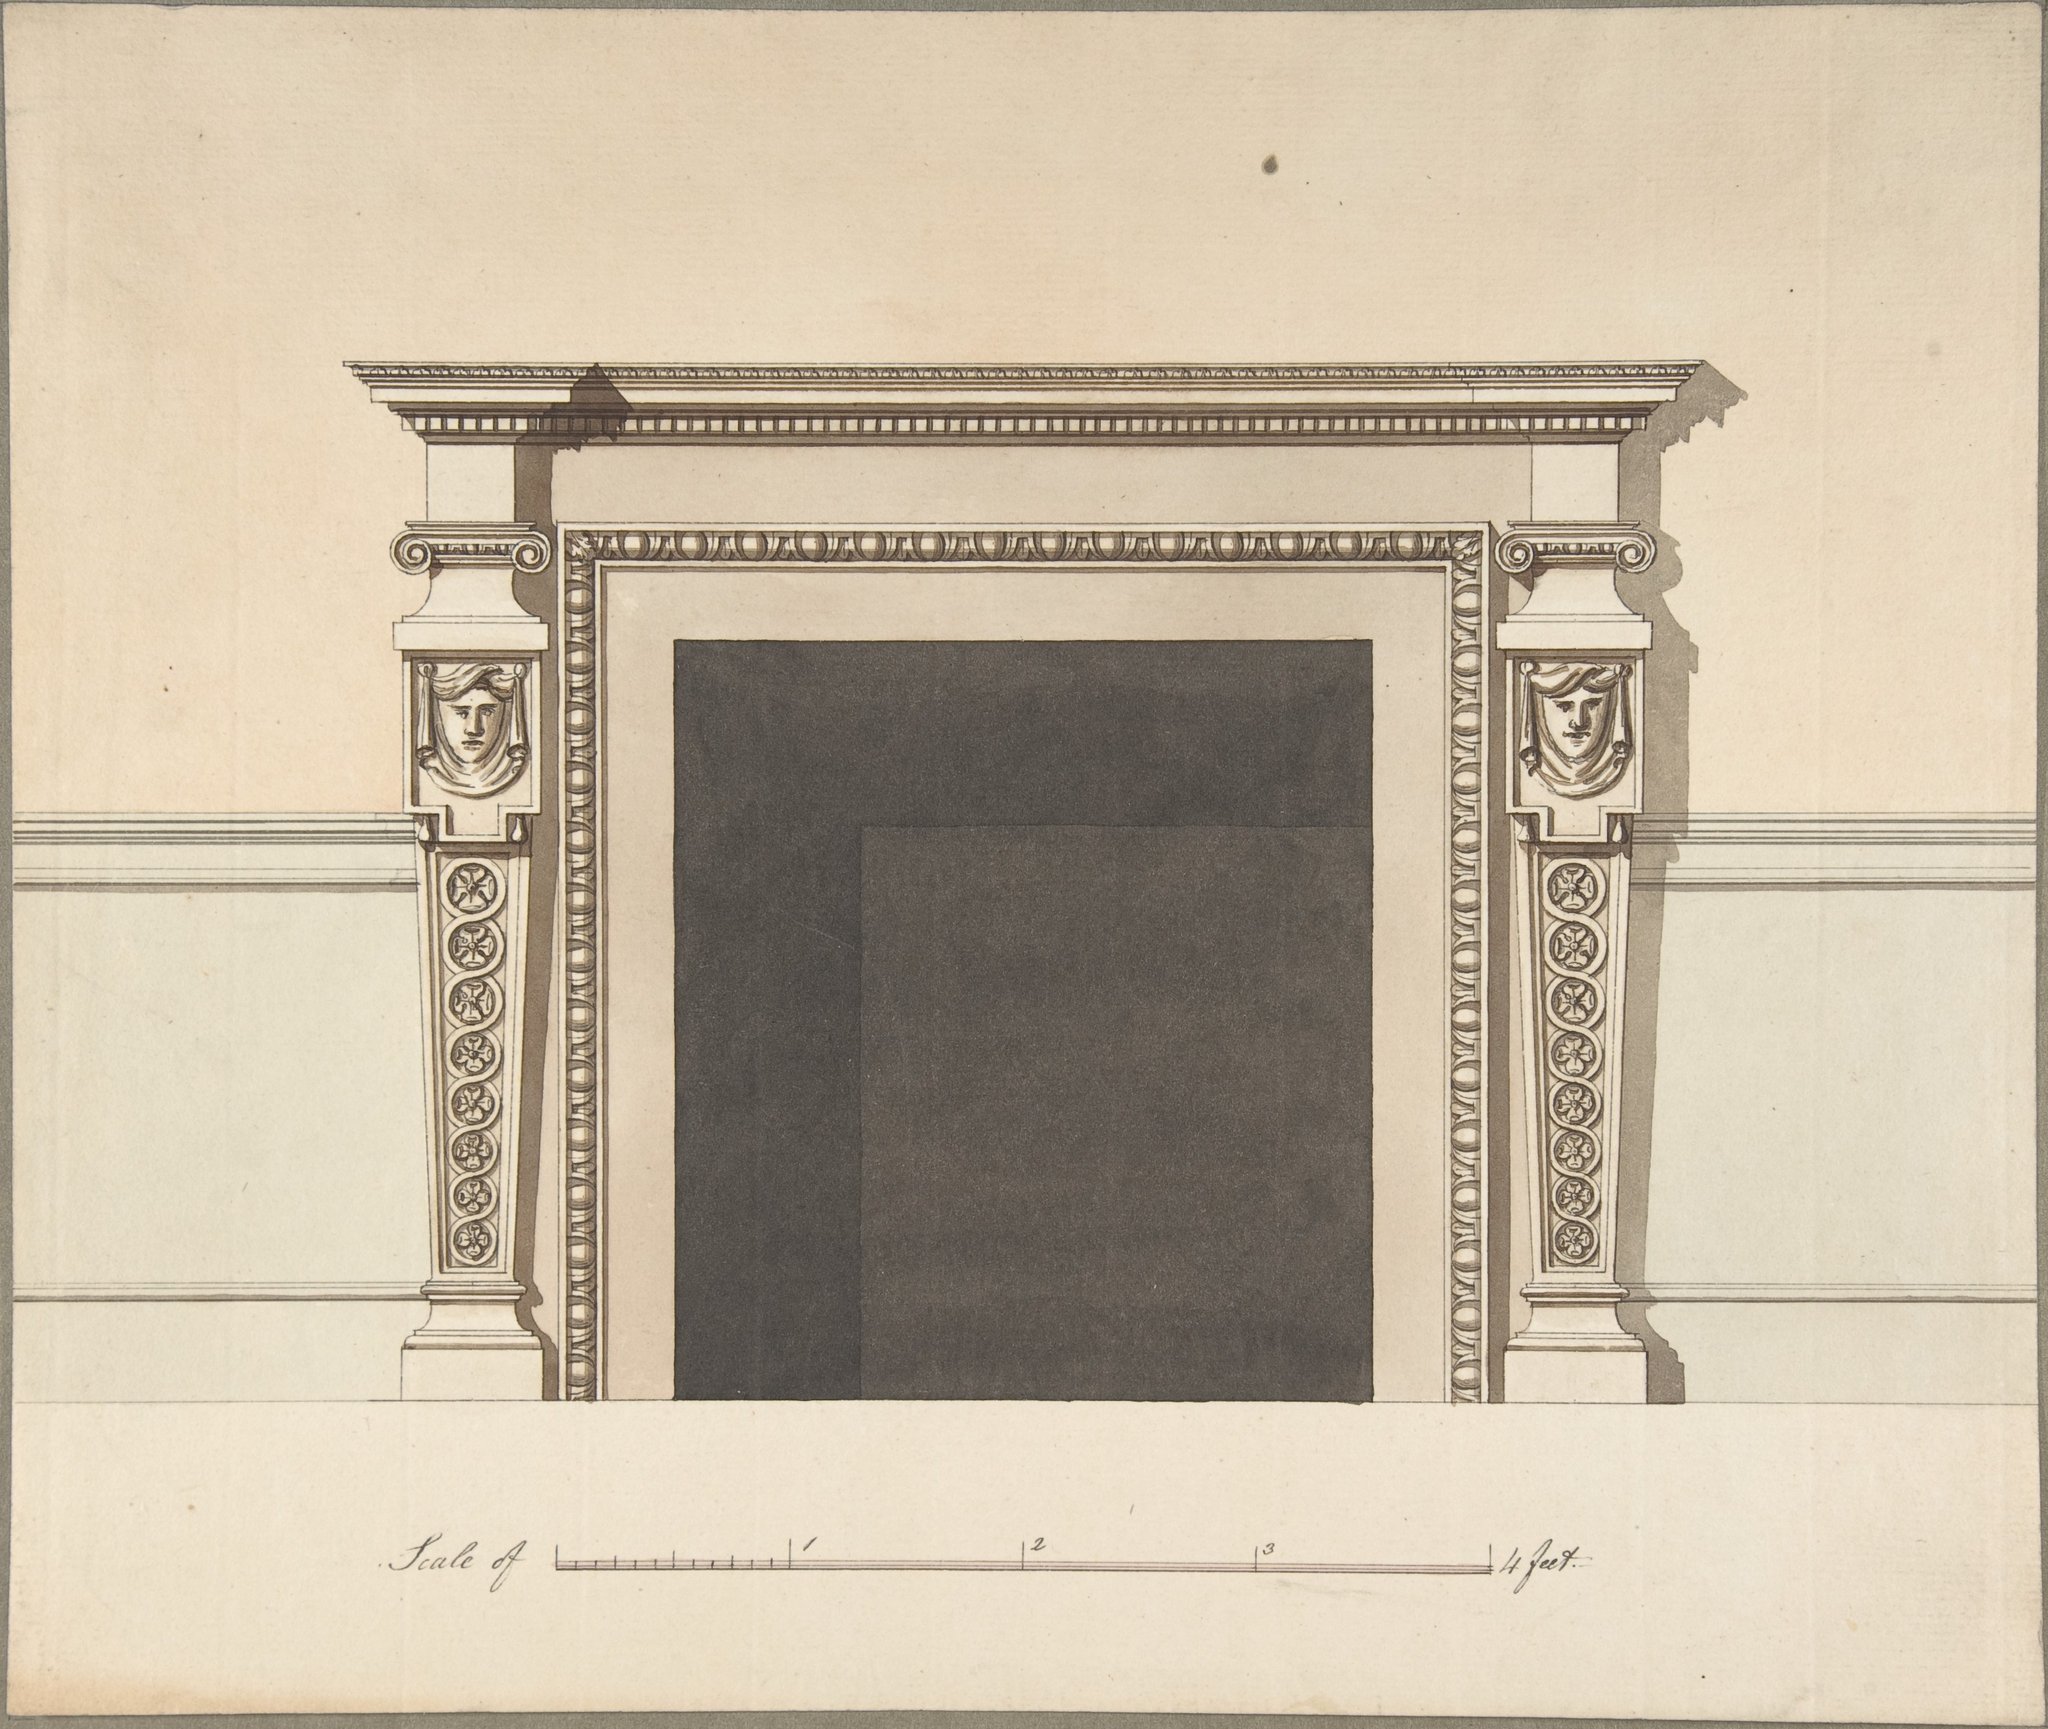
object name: drawing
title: Design for a Chimneypiece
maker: john yenn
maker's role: artist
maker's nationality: british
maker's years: 1750-1821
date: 1767-1833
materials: ink, watercolor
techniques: brush, pen, wash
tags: fireplaces